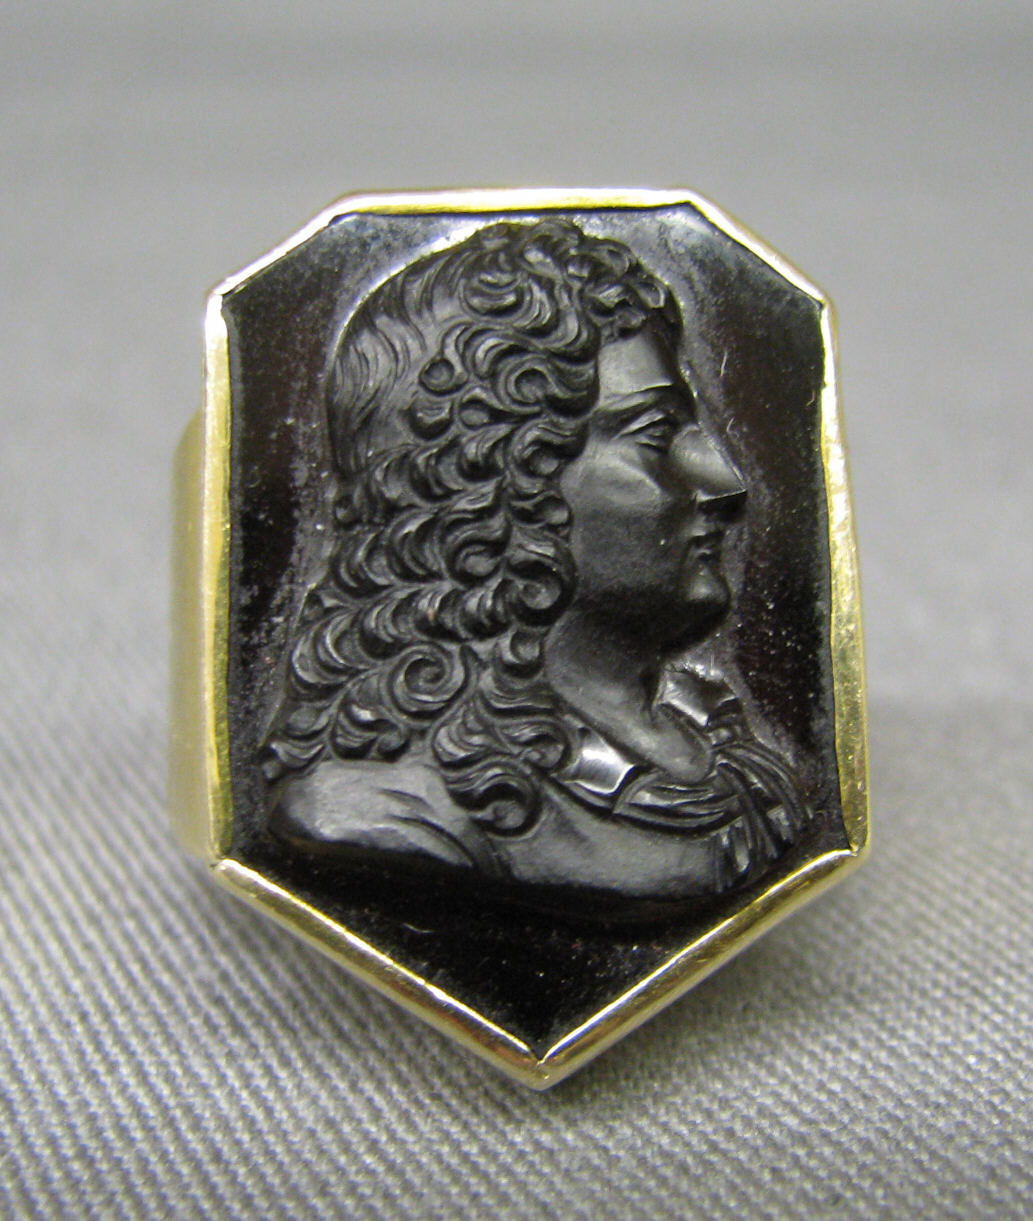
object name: ring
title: Bust of a man in a wig, possibly a writer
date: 1701-1800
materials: gold, gemstone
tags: men,profiles